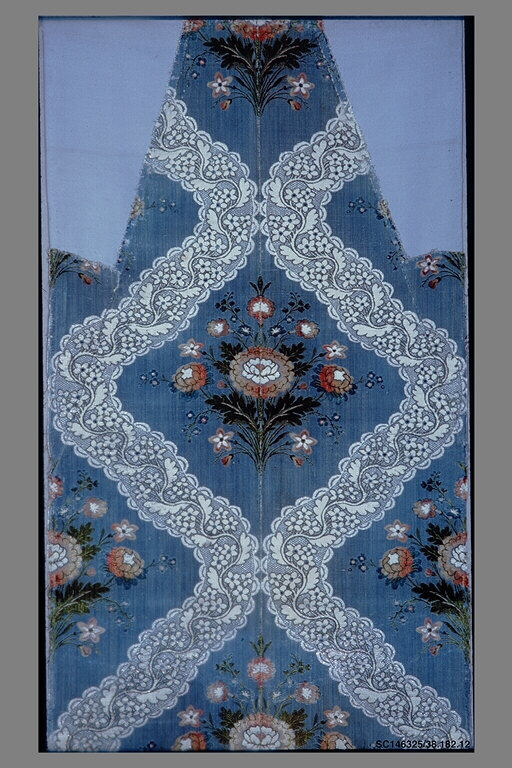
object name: piece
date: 1750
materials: metal thread, silk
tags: flowers